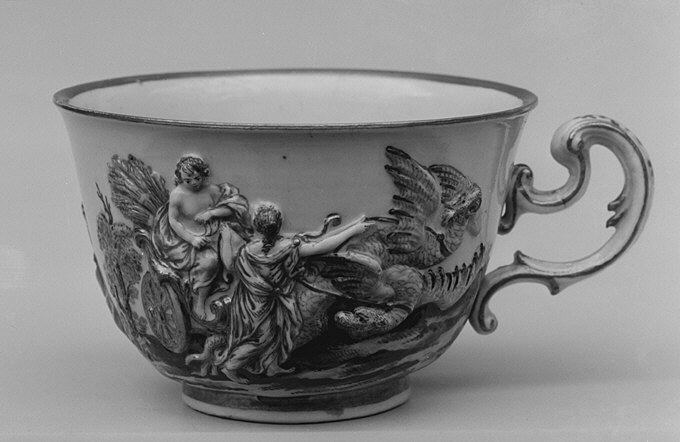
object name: teacup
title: Tea cup (part of a service)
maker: doccia porcelain manufactory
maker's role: manufactory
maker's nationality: italian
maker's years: 1737-1896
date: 1760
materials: hard paste porcelain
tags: birds,men,women